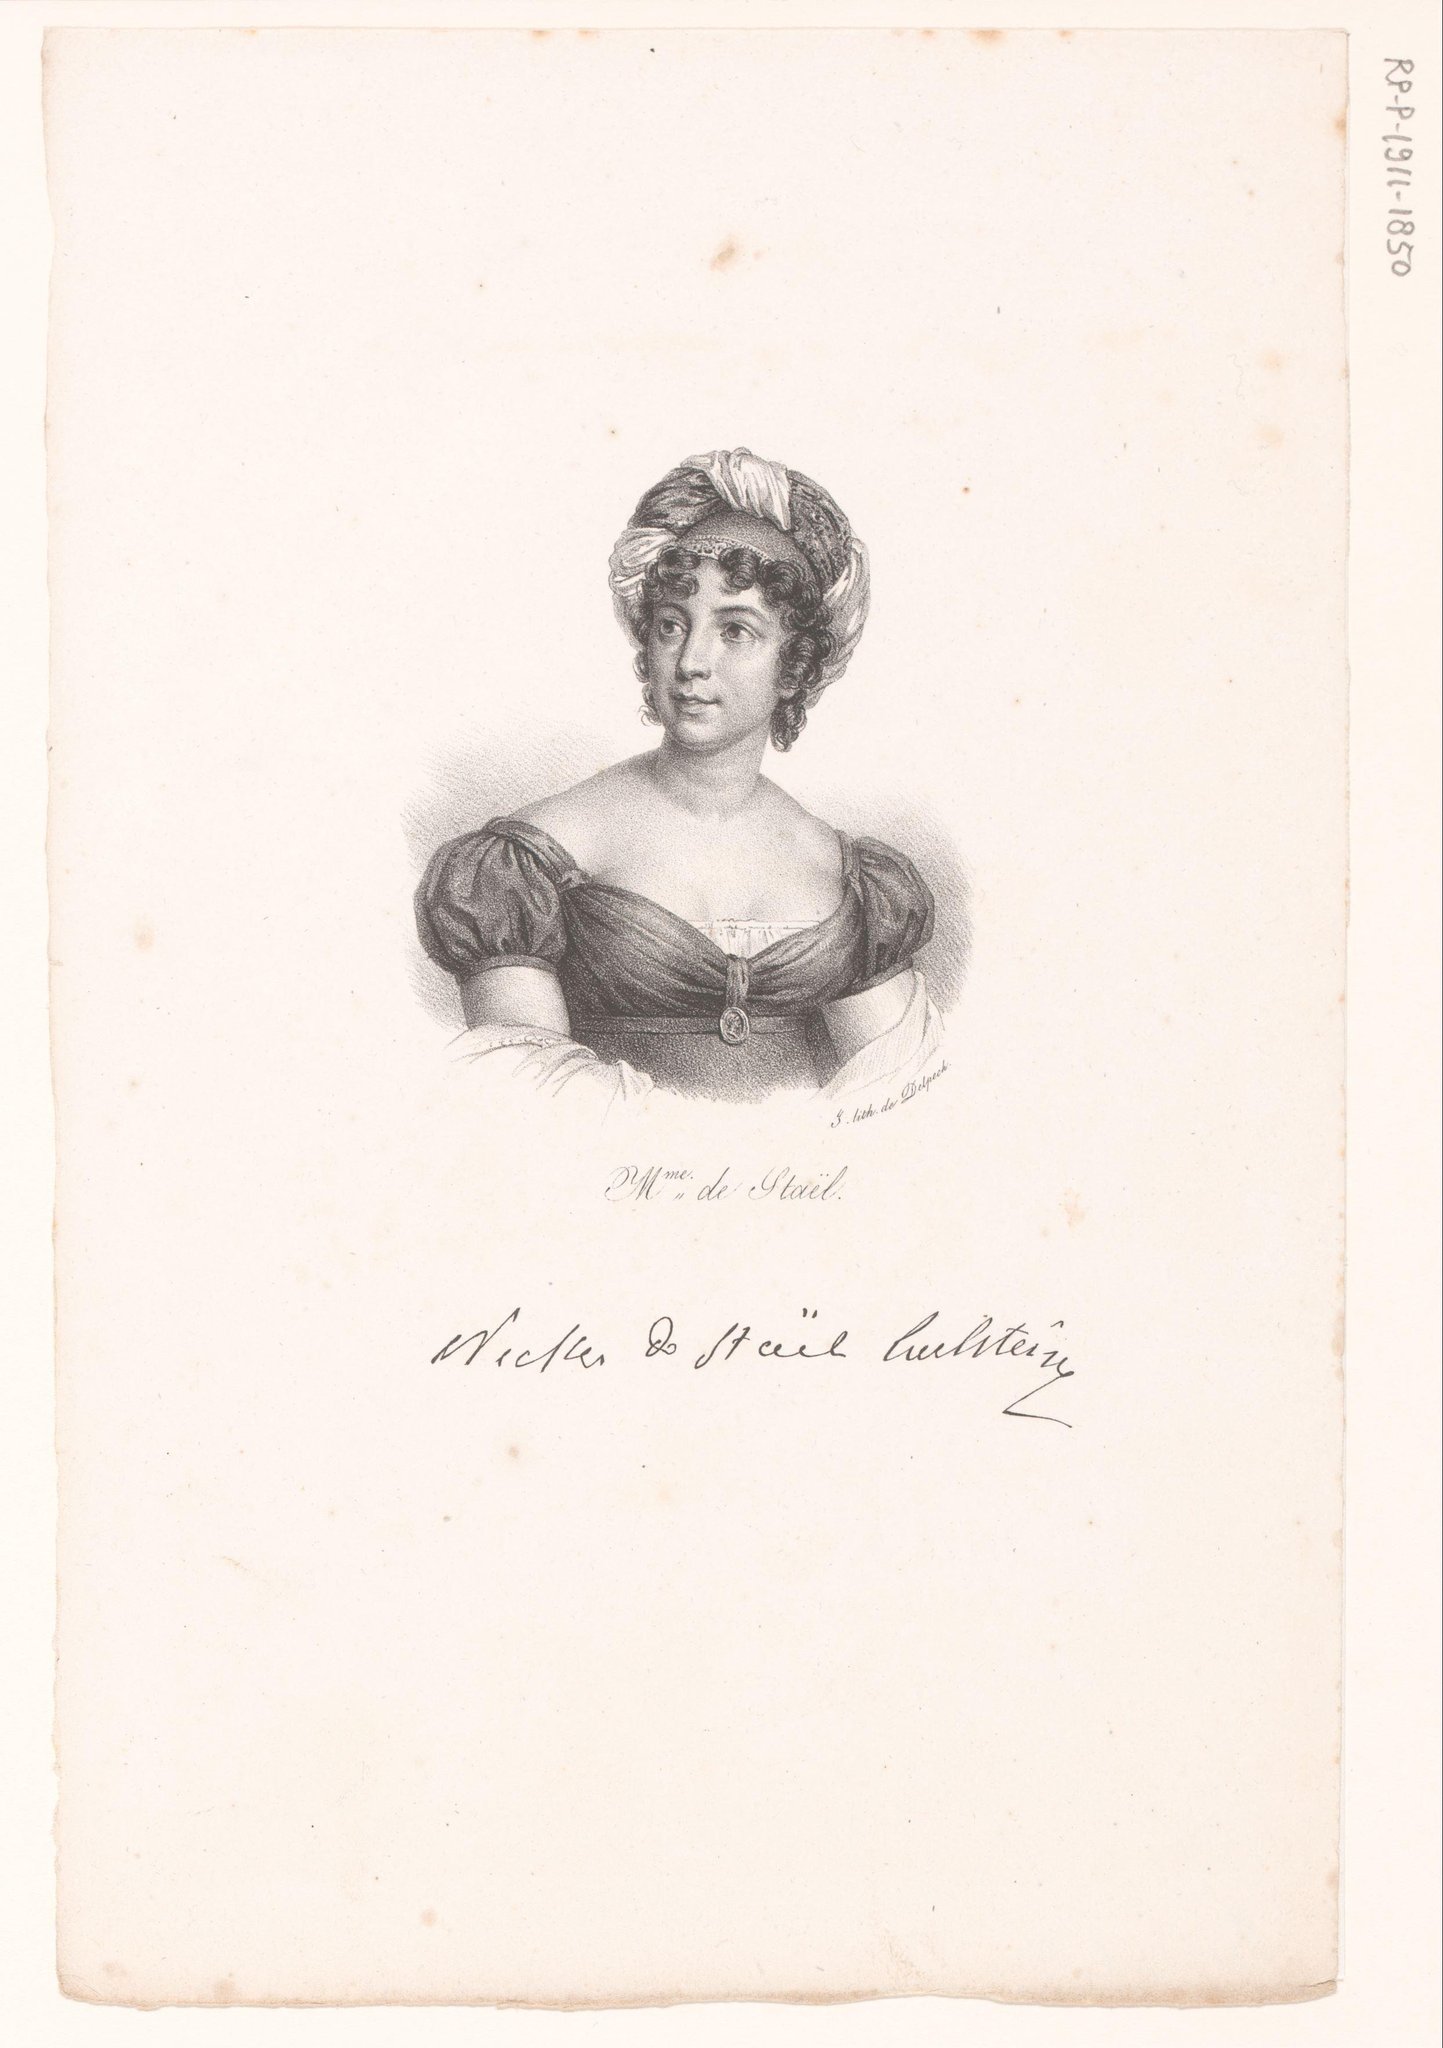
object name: print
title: M.me de Staël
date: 1818-1842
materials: paper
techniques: lithograph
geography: paris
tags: paris, historical persons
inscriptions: collector's mark: Lugt 2228a